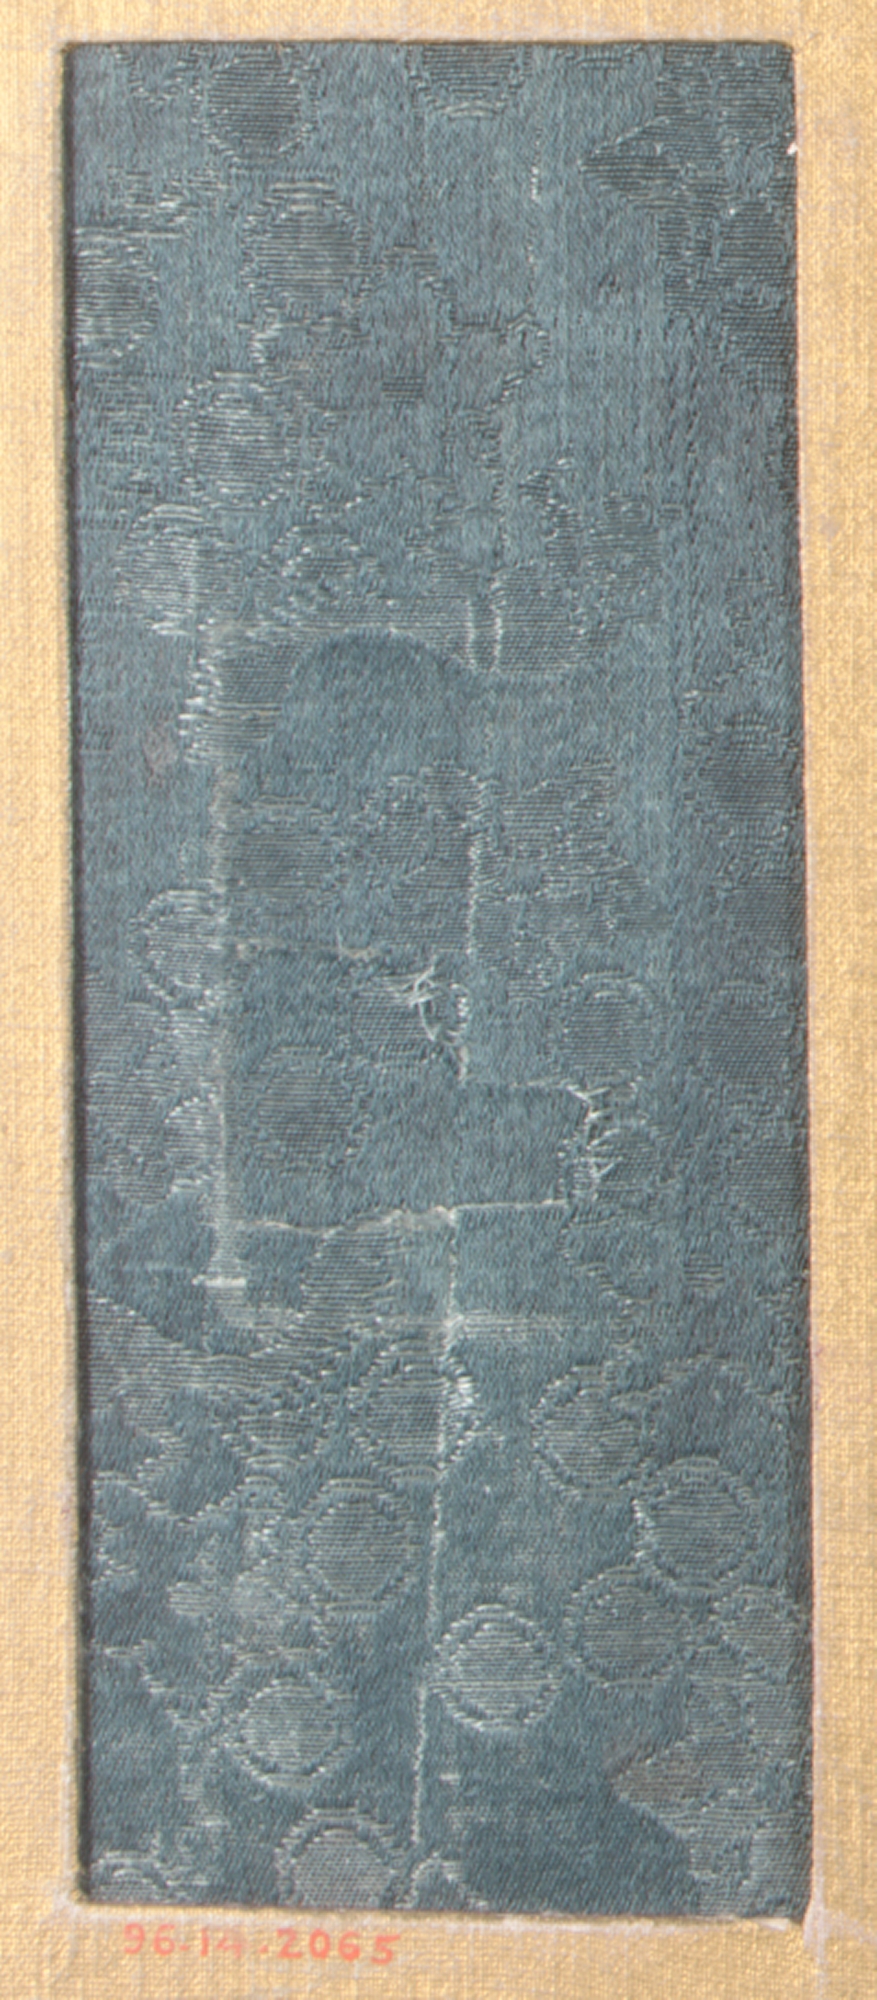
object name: piece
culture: japanese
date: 1701-1900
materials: silk